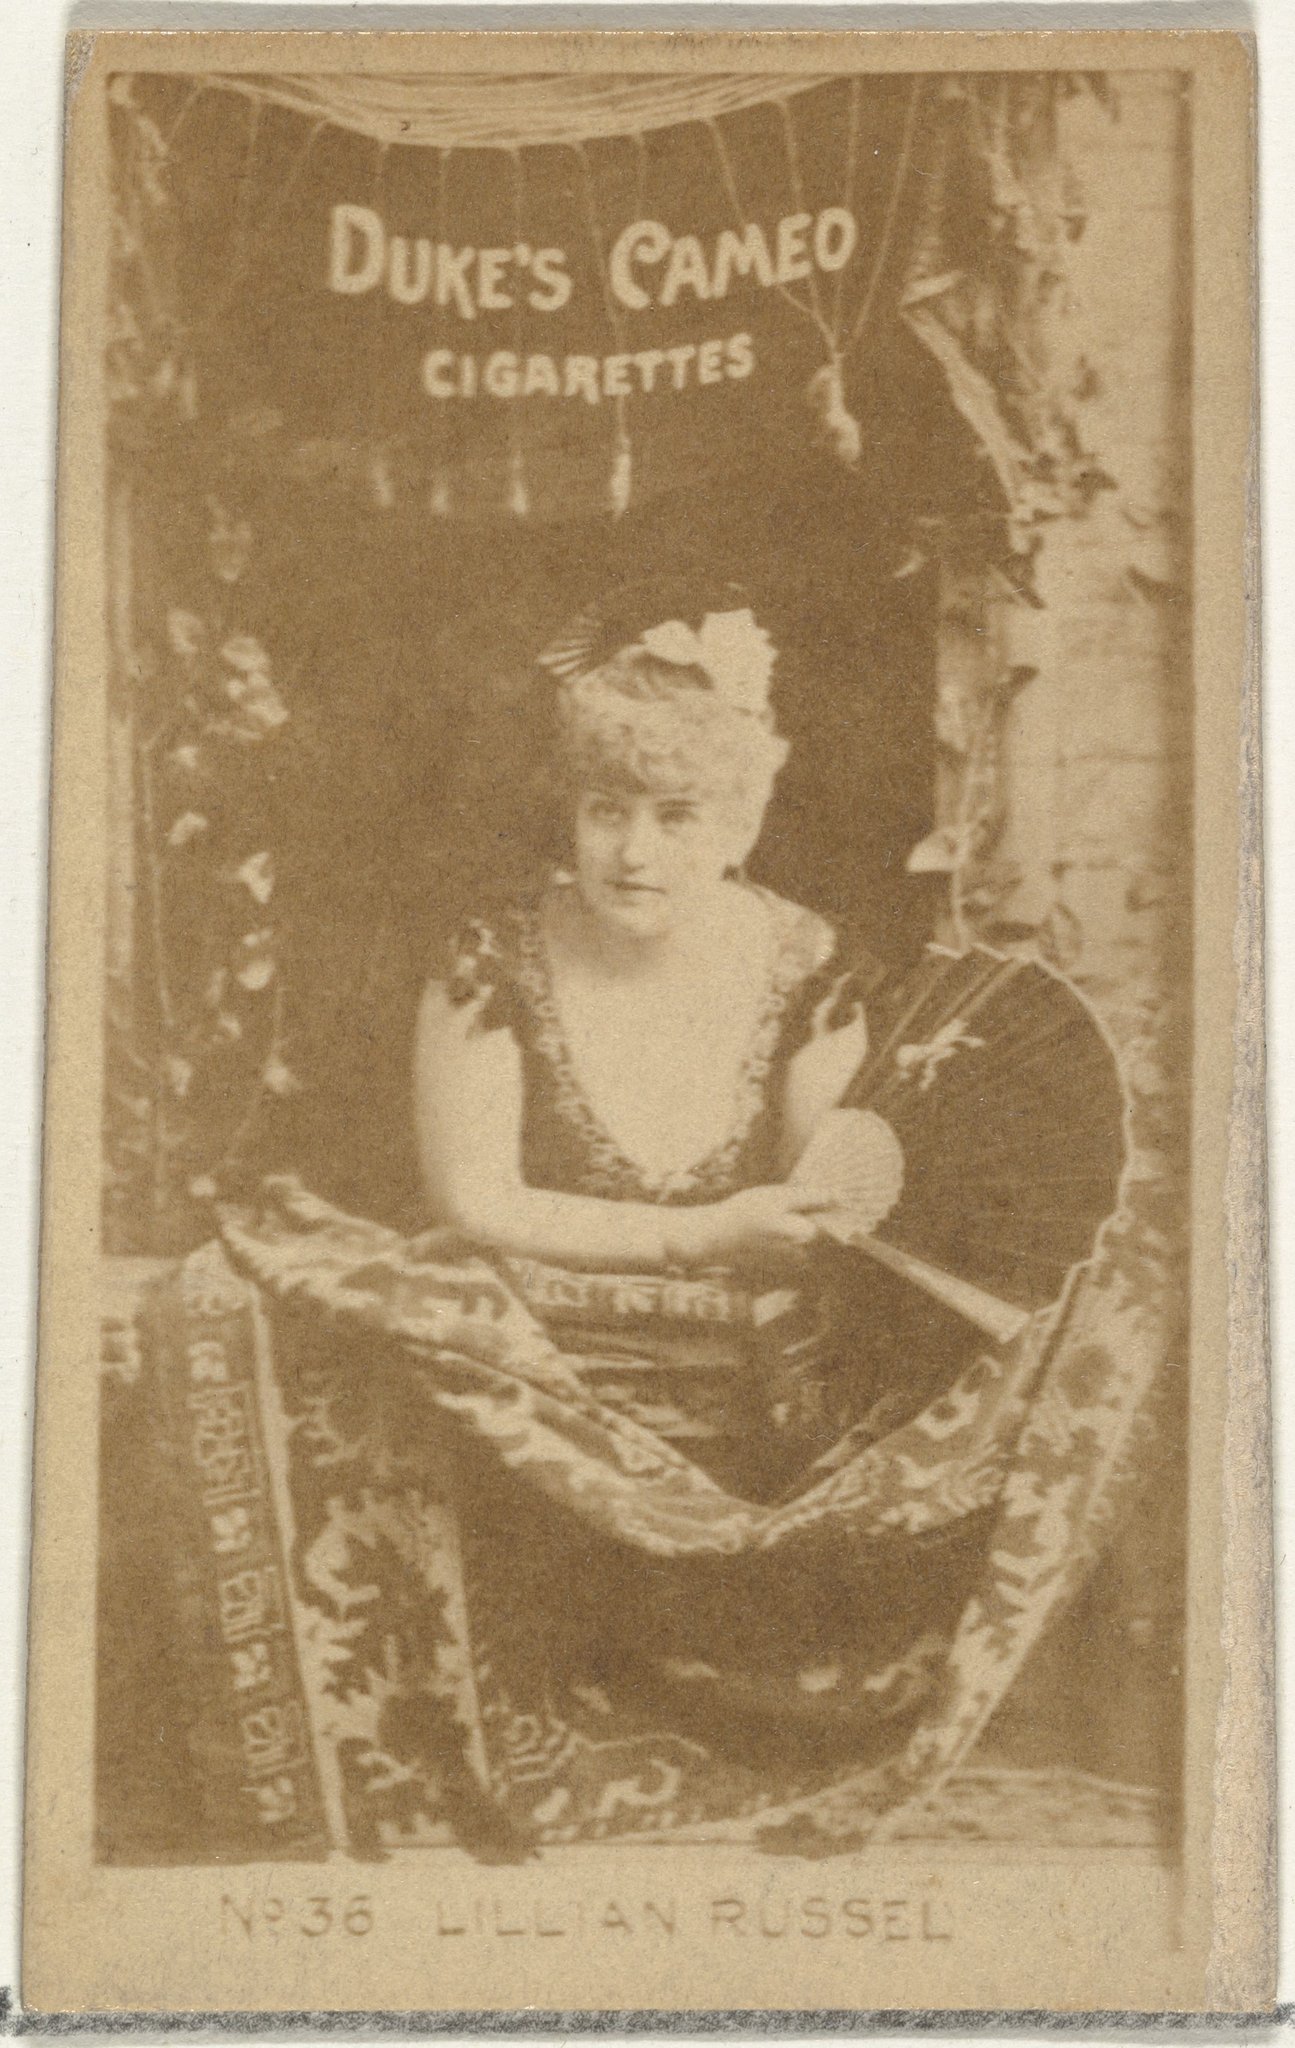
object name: photograph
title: Card Number 36, Lillian Russell, from the Actors and Actresses series (N145-4) issued by Duke Sons & Co. to promote Cameo Cigarettes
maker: w. duke, sons & co.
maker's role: publisher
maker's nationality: american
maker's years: 1870-1920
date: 1880-1889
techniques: albumen silver print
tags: portraits,women,actresses